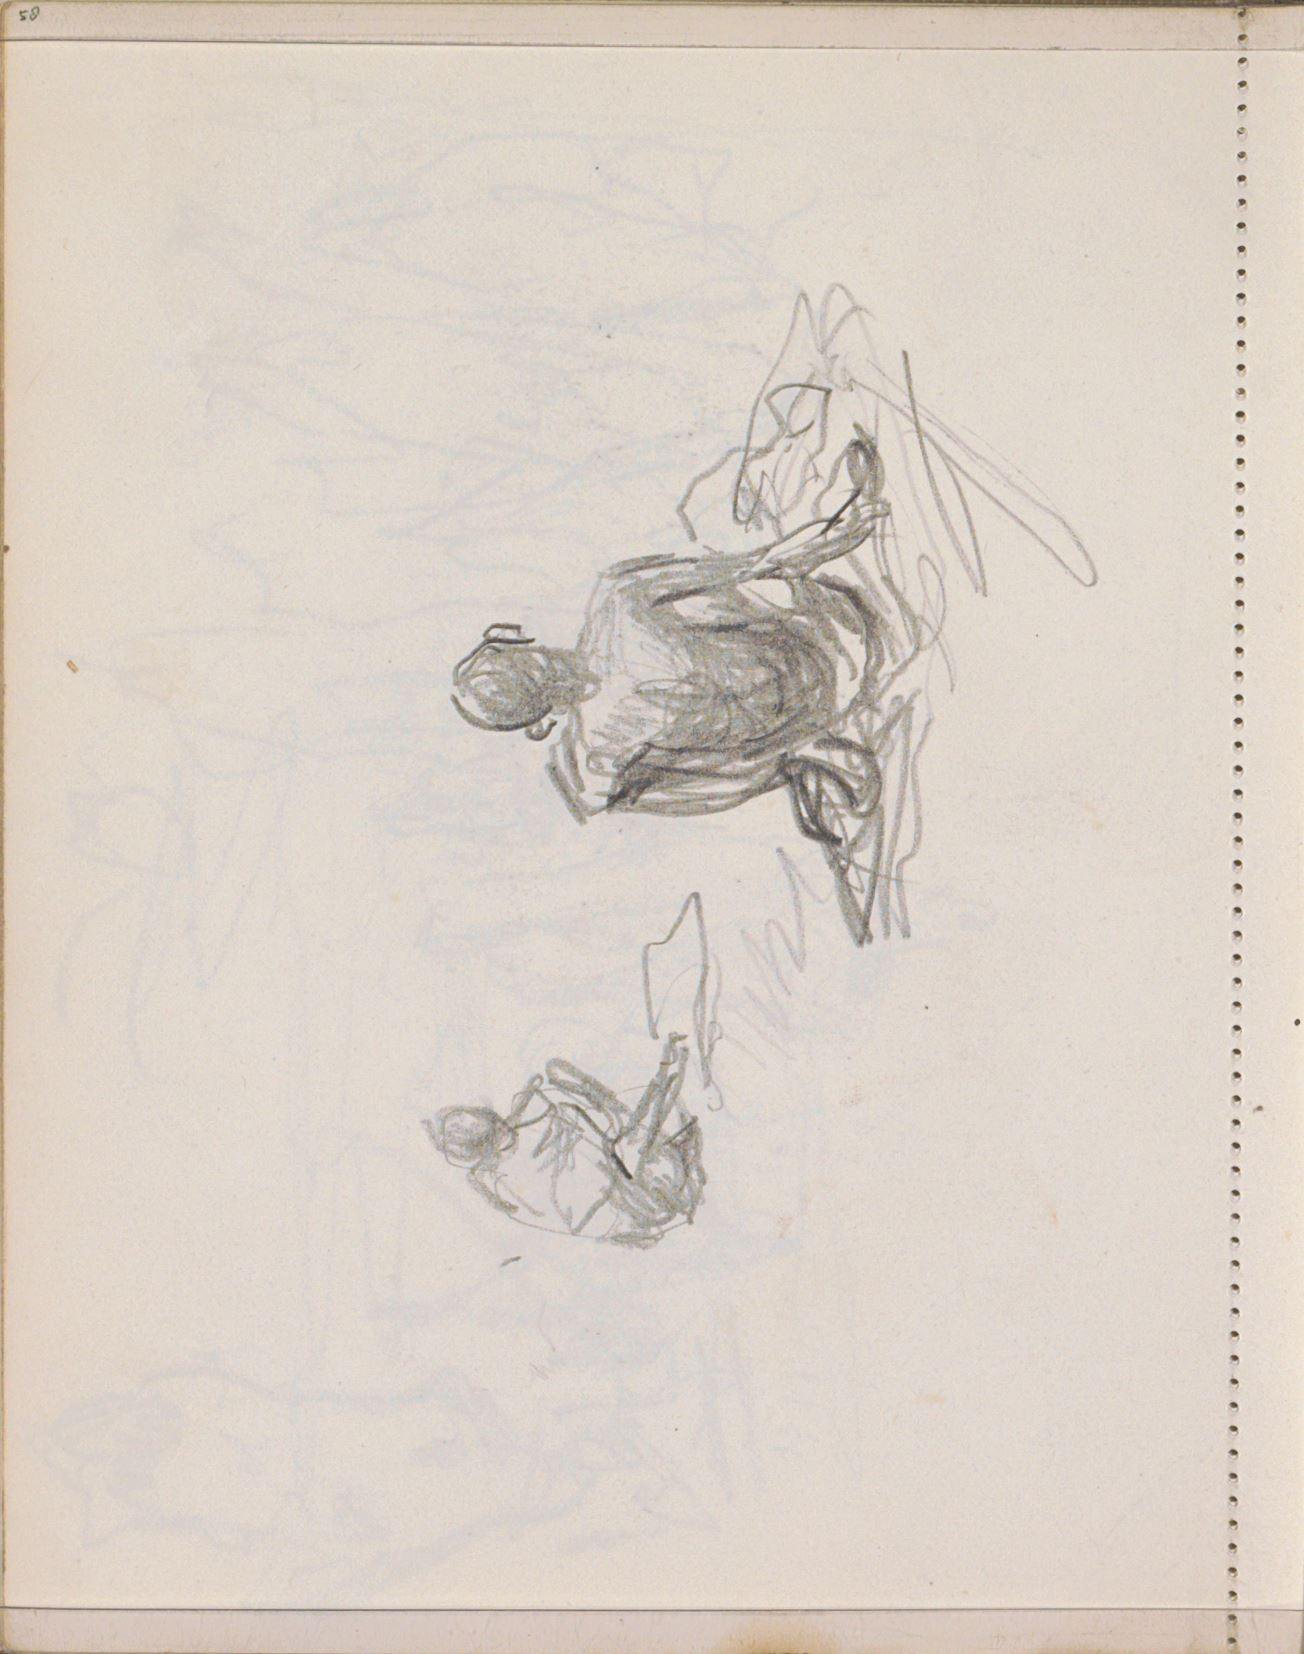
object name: sketchbook leaf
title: Zittende Indiërs, op de rug gezien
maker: marius bauer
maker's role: draughtsman, print maker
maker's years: 1867-1932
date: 1924-1925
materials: paper, pencil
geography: india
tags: sitting figure, asiatic races and peoples: indians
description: Pagina 58 uit een schetsboek met 75 bladen.